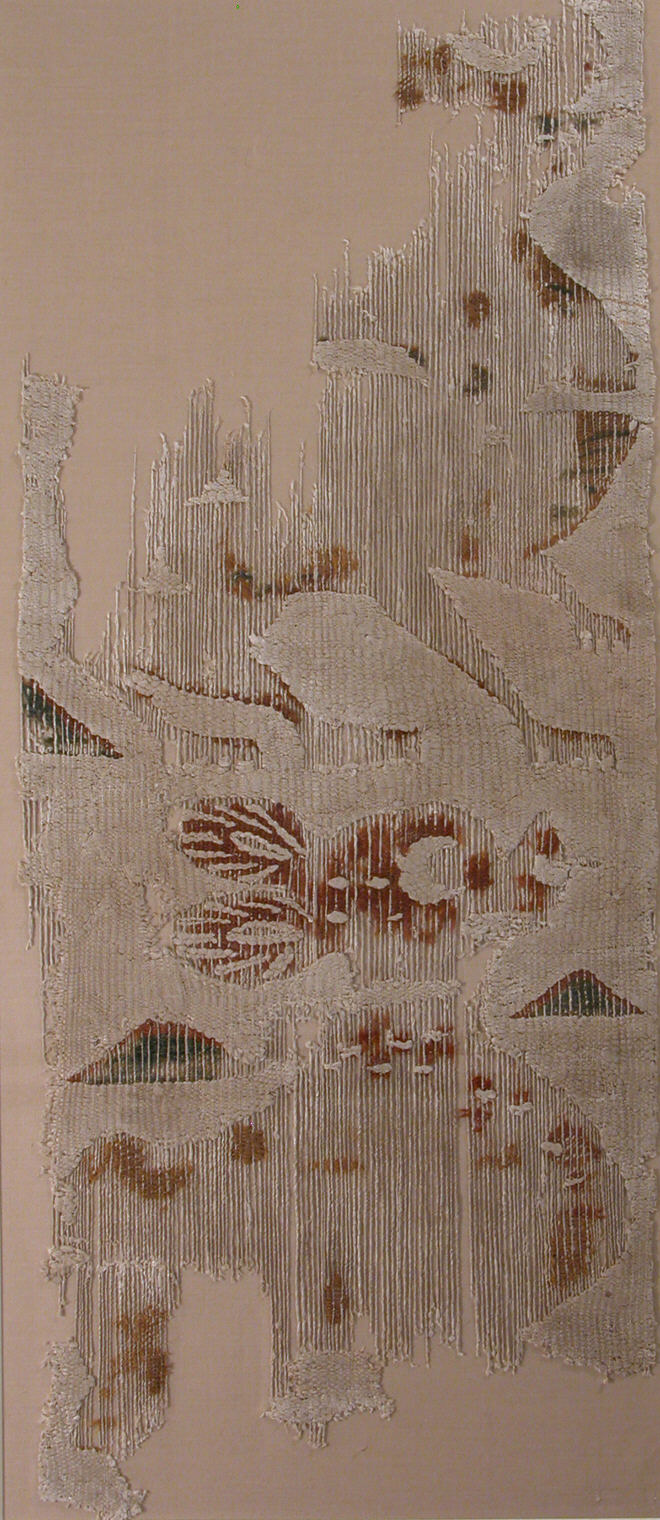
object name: textile fragment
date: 801-1000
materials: linen, wool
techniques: weave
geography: egypt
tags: animals